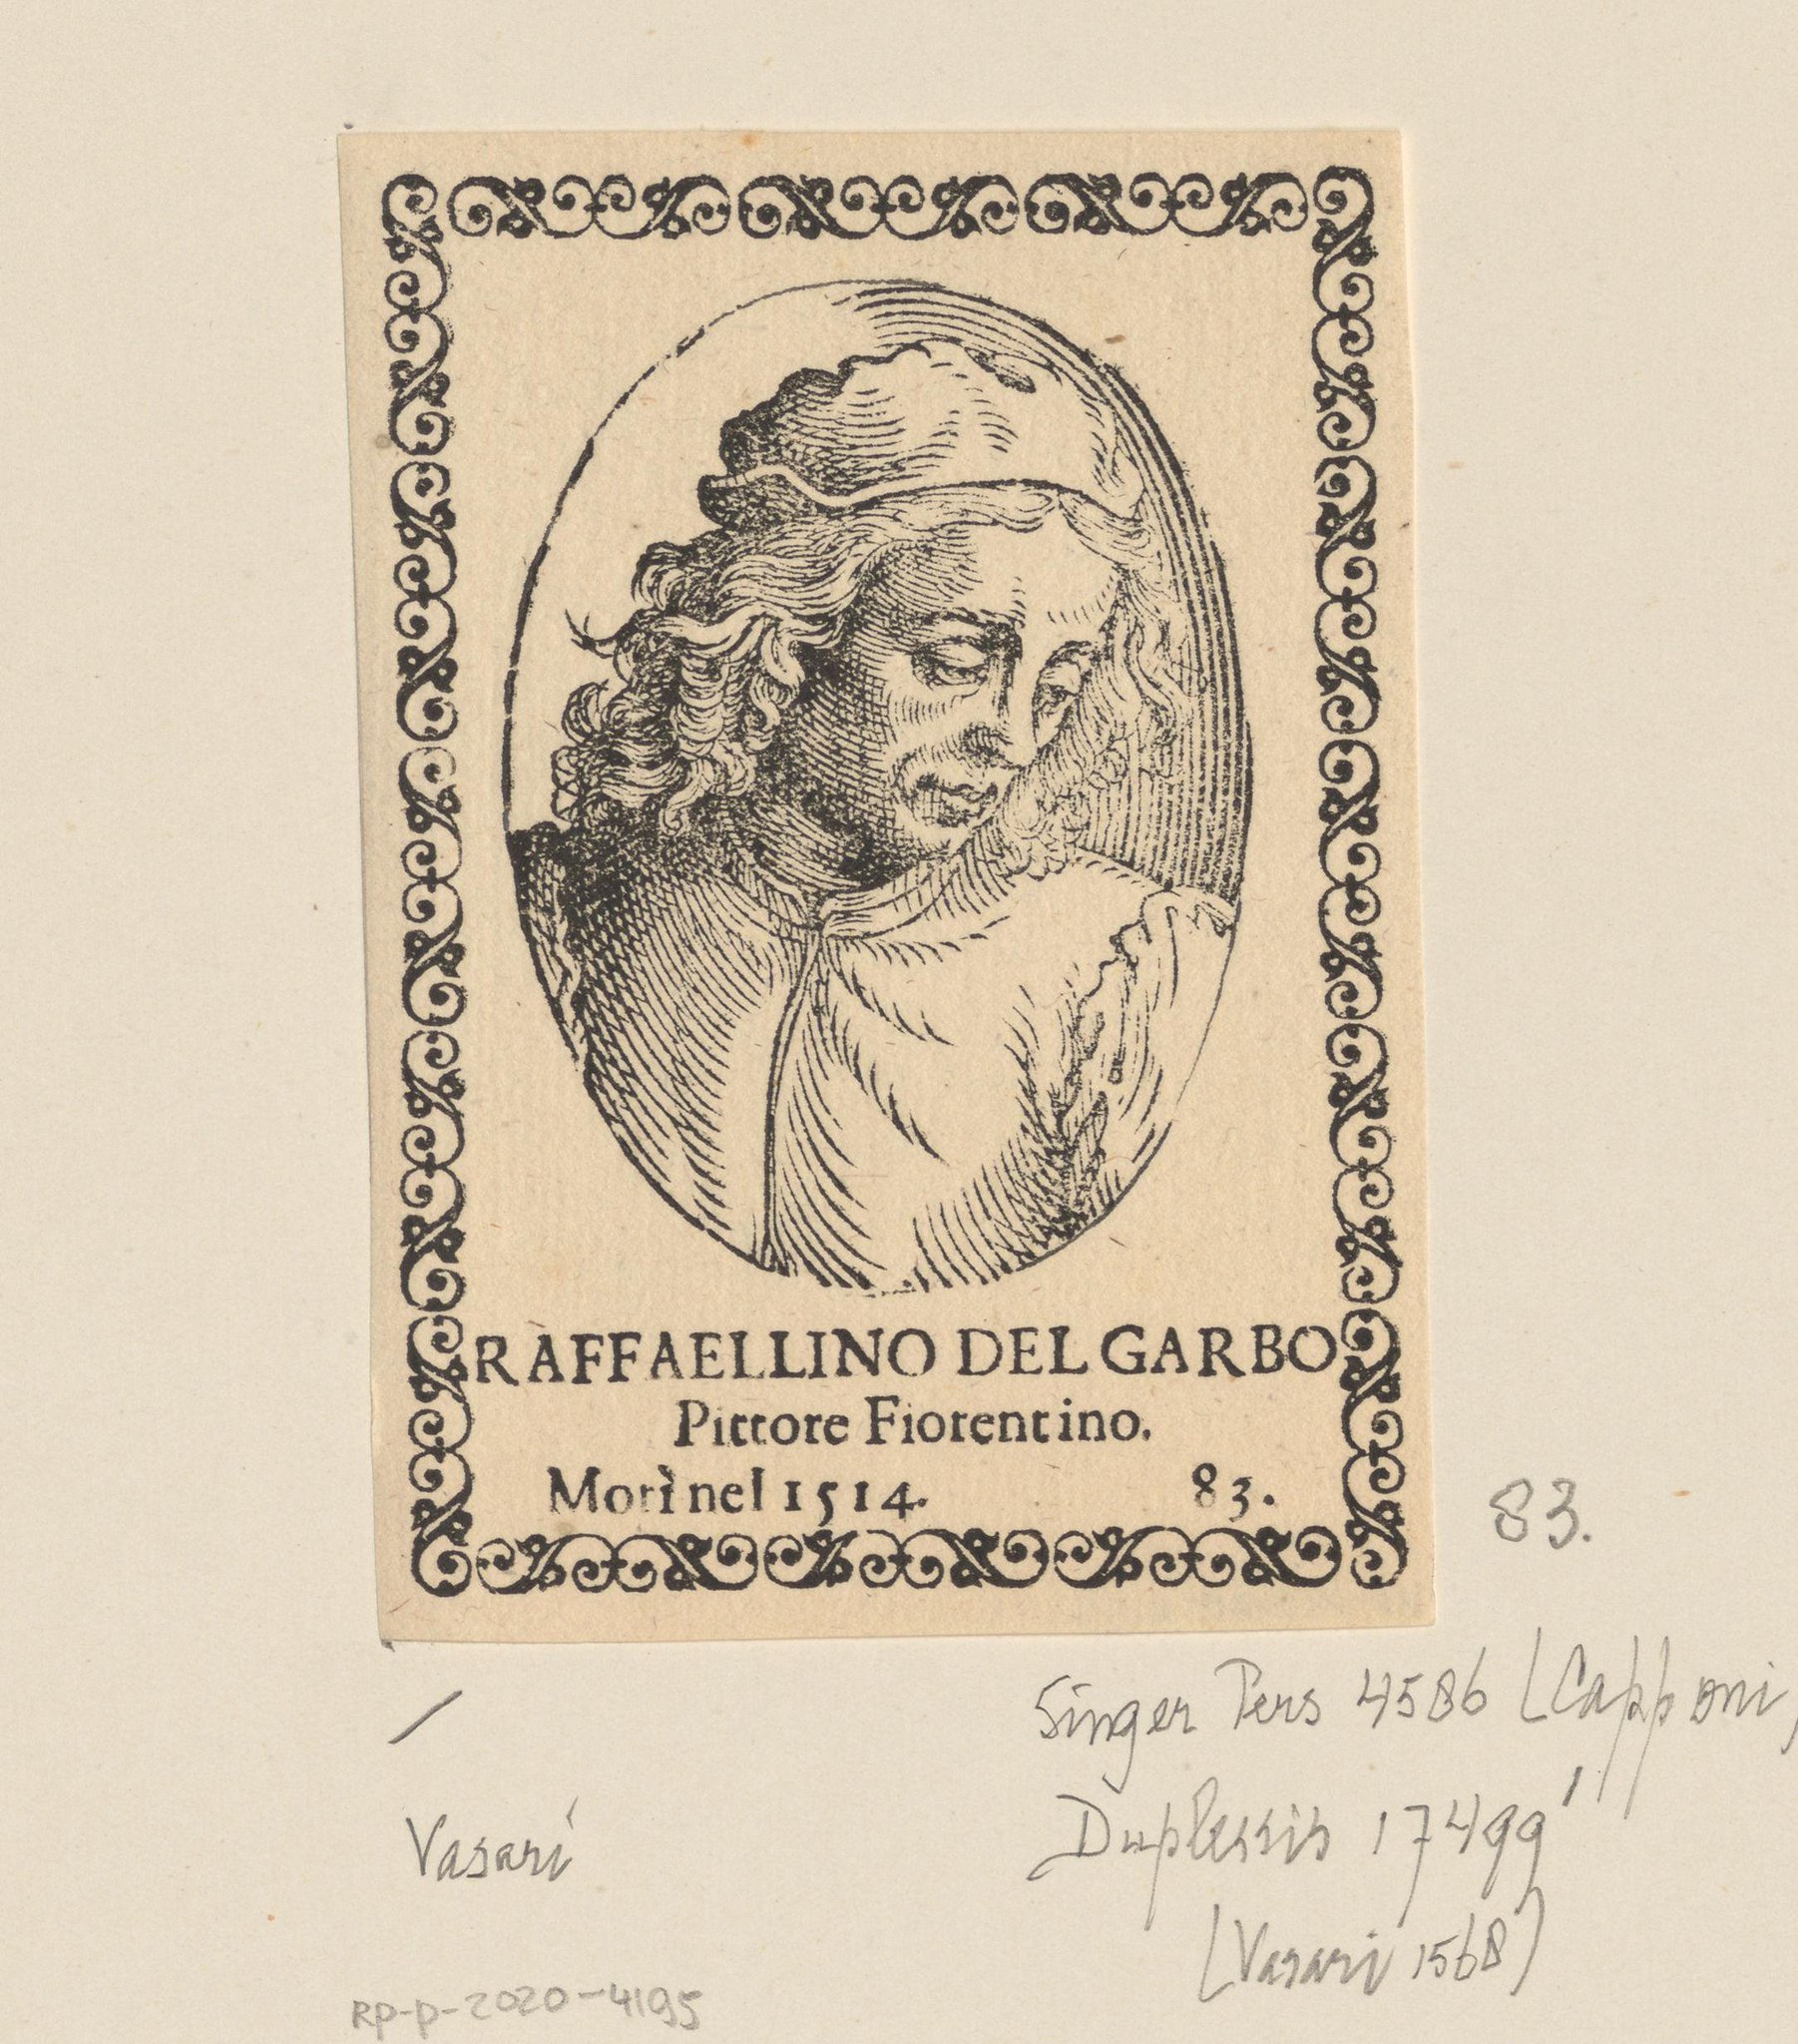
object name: print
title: Portret van Raffaelino del Garbo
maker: Anonymous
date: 1568-1650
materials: paper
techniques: letterpress printing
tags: painter, historical persons, portrait, self-portrait of painter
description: Prent uit een onbekende editie van: Vasari, Giorgio. Le Vite de' più eccellenti pittori, scultori, e architettori da Cimabue insino a' tempi nostri. S.l.s.n., [1568]. De prent is met een andere omlijsting gebruikt in de editie uit 1568, en mogelijk in de editie uit 1647.